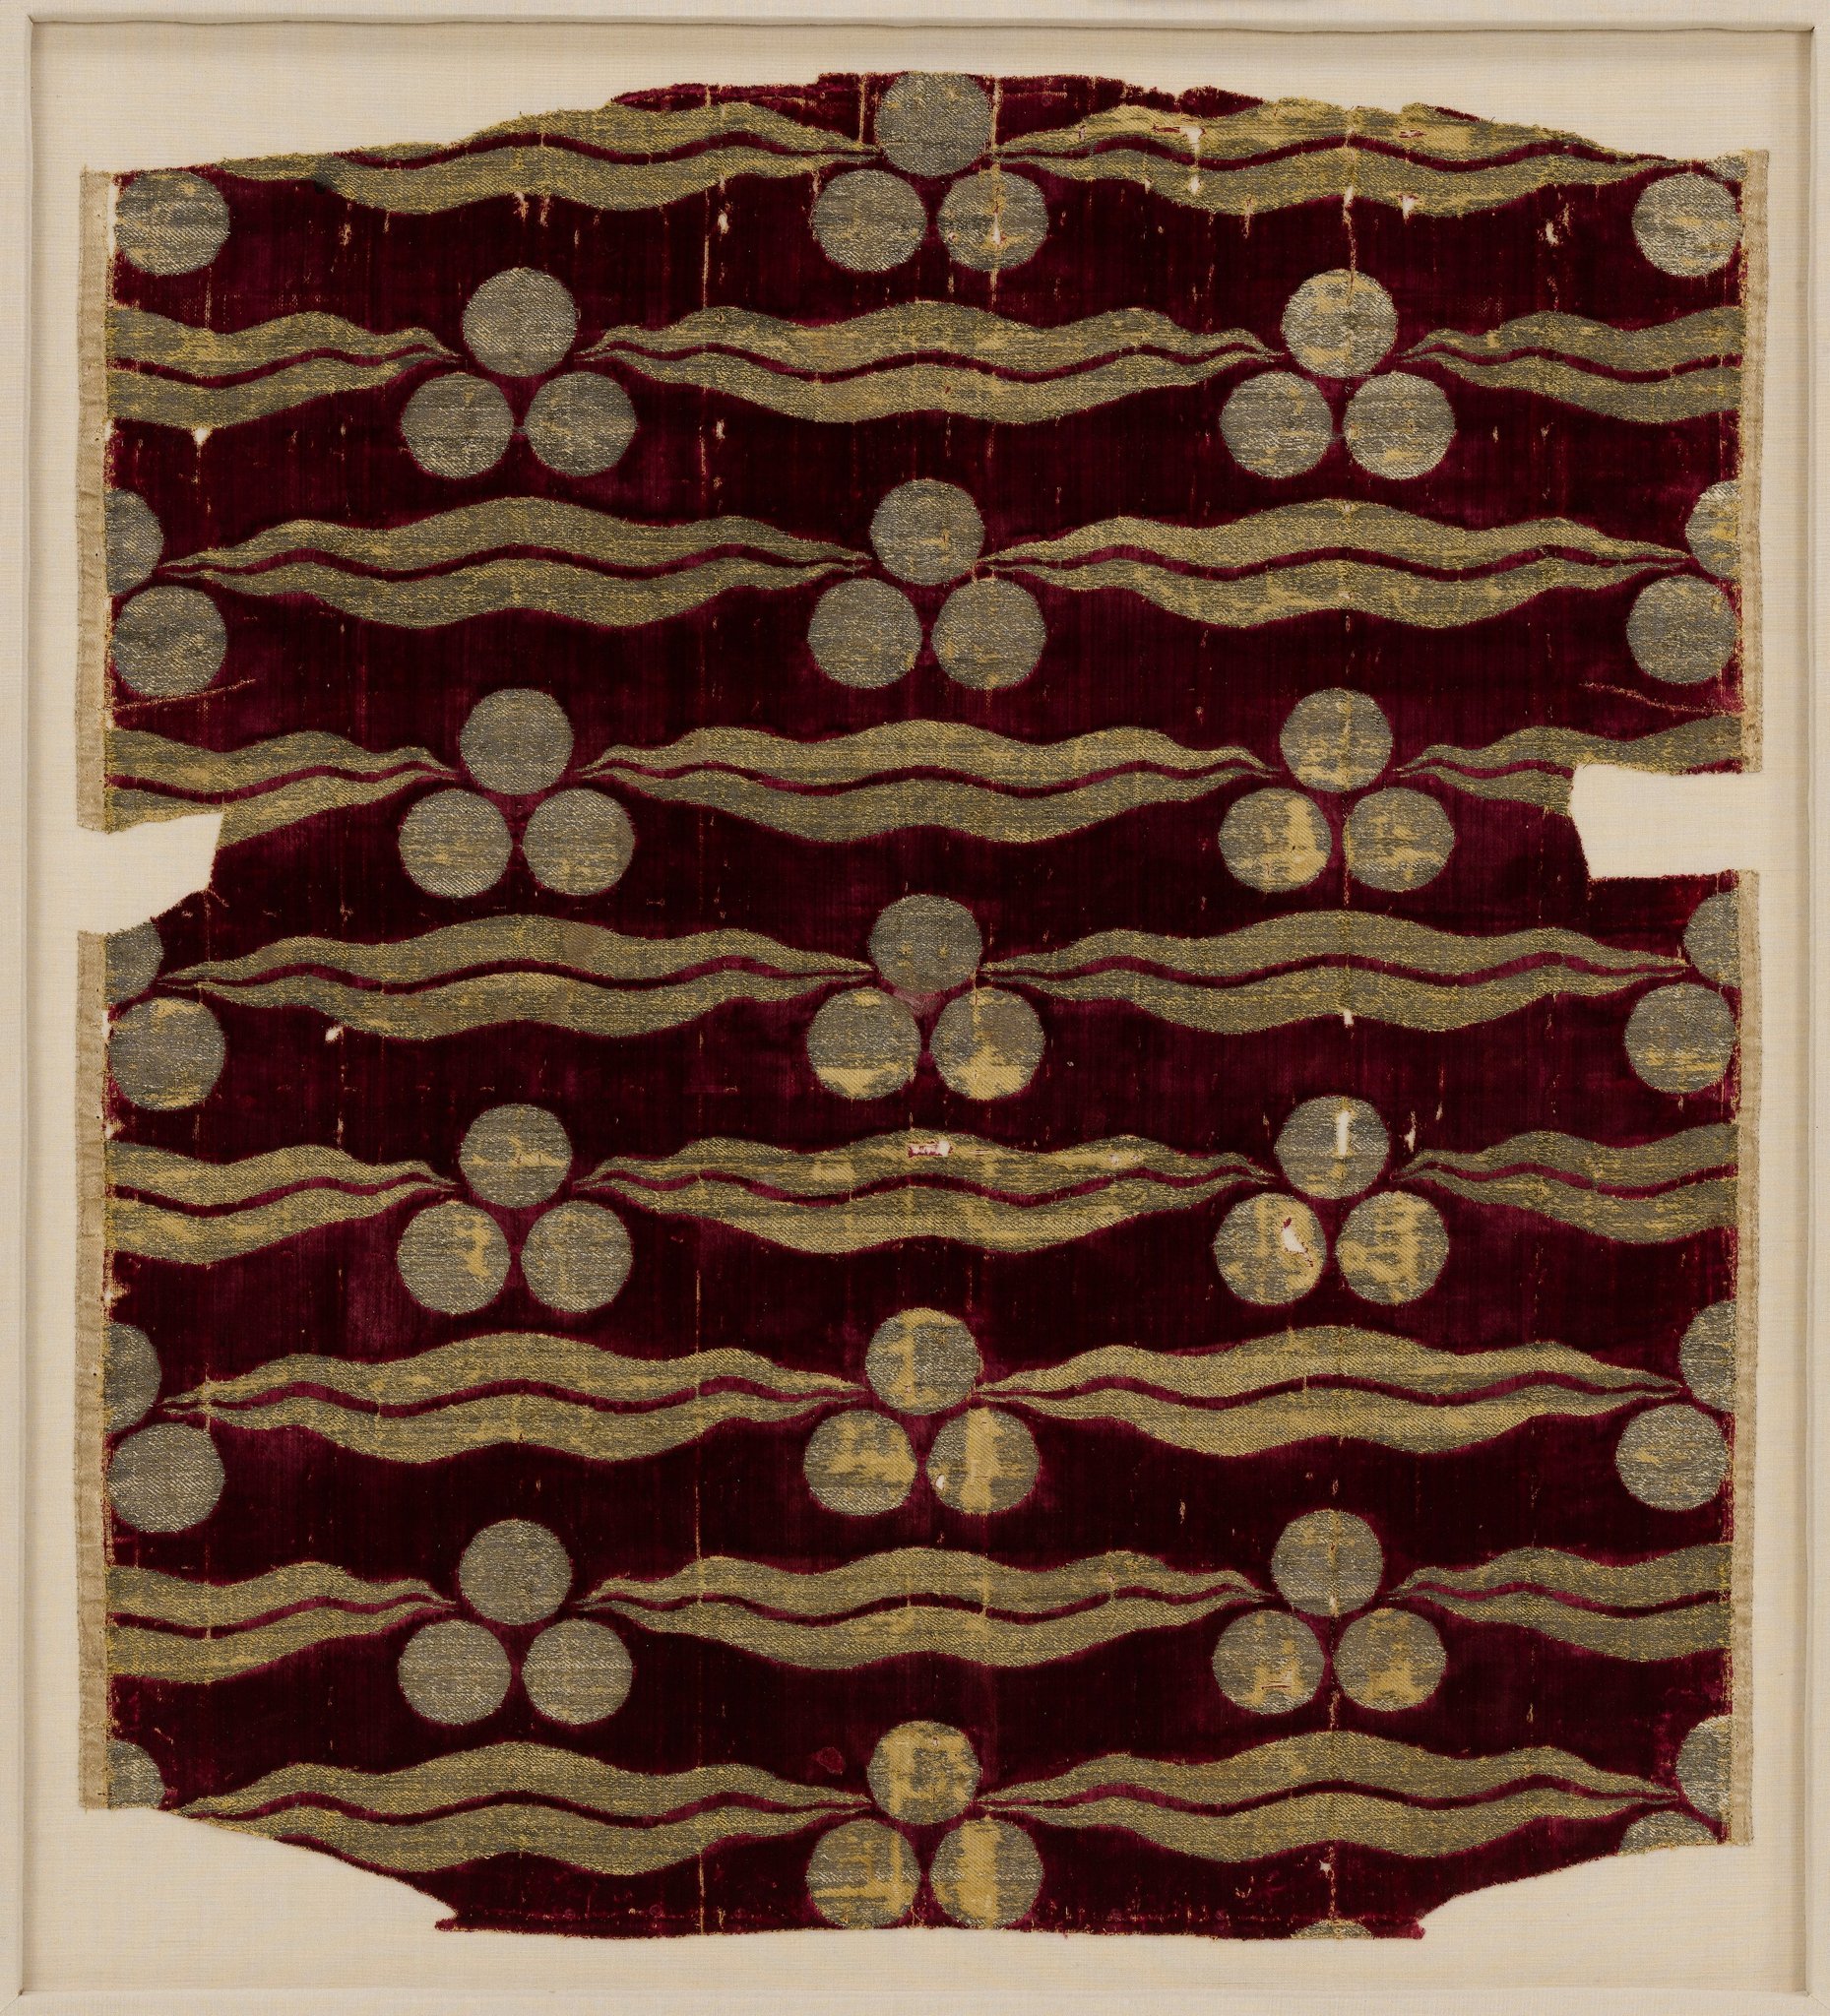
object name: textile fragment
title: Fragmentary Silk Velvet with Repeating Tiger-stripe and 'Chintamani' Design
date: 1451-1500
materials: metal thread, silk, velvet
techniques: brocade, cutting, voiding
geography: turkey